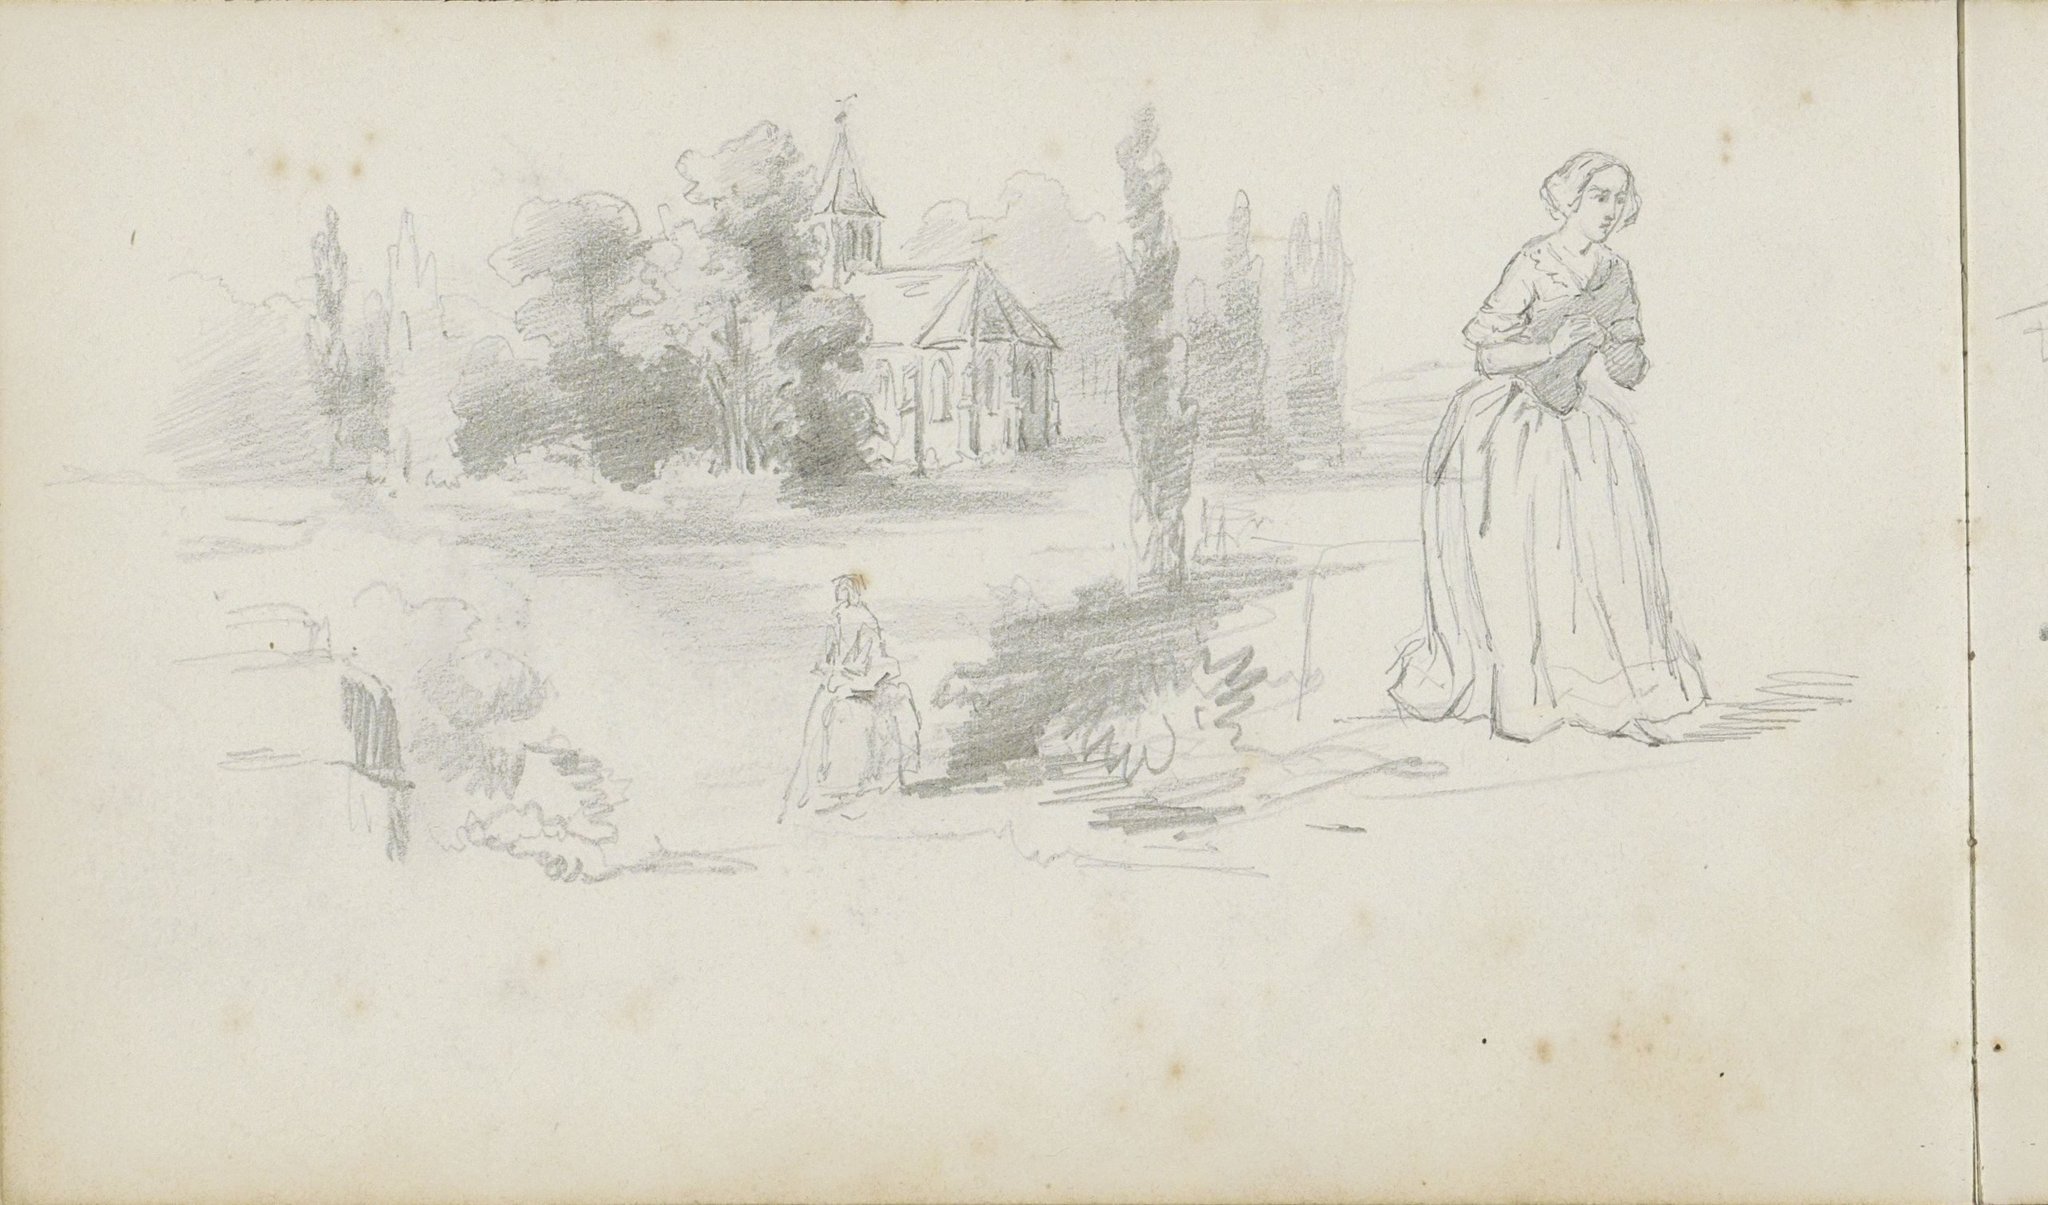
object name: sketchbook leaf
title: Kerk in een landschap, een wandelende en een staande vrouw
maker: charles rochussen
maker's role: draughtsman, painter, print maker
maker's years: 1814-1894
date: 1840-1860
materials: paper, pencil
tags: church (exterior), standing figure - aa - female human figure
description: Blad 17 verso uit een schetsboek met 38 bladen.